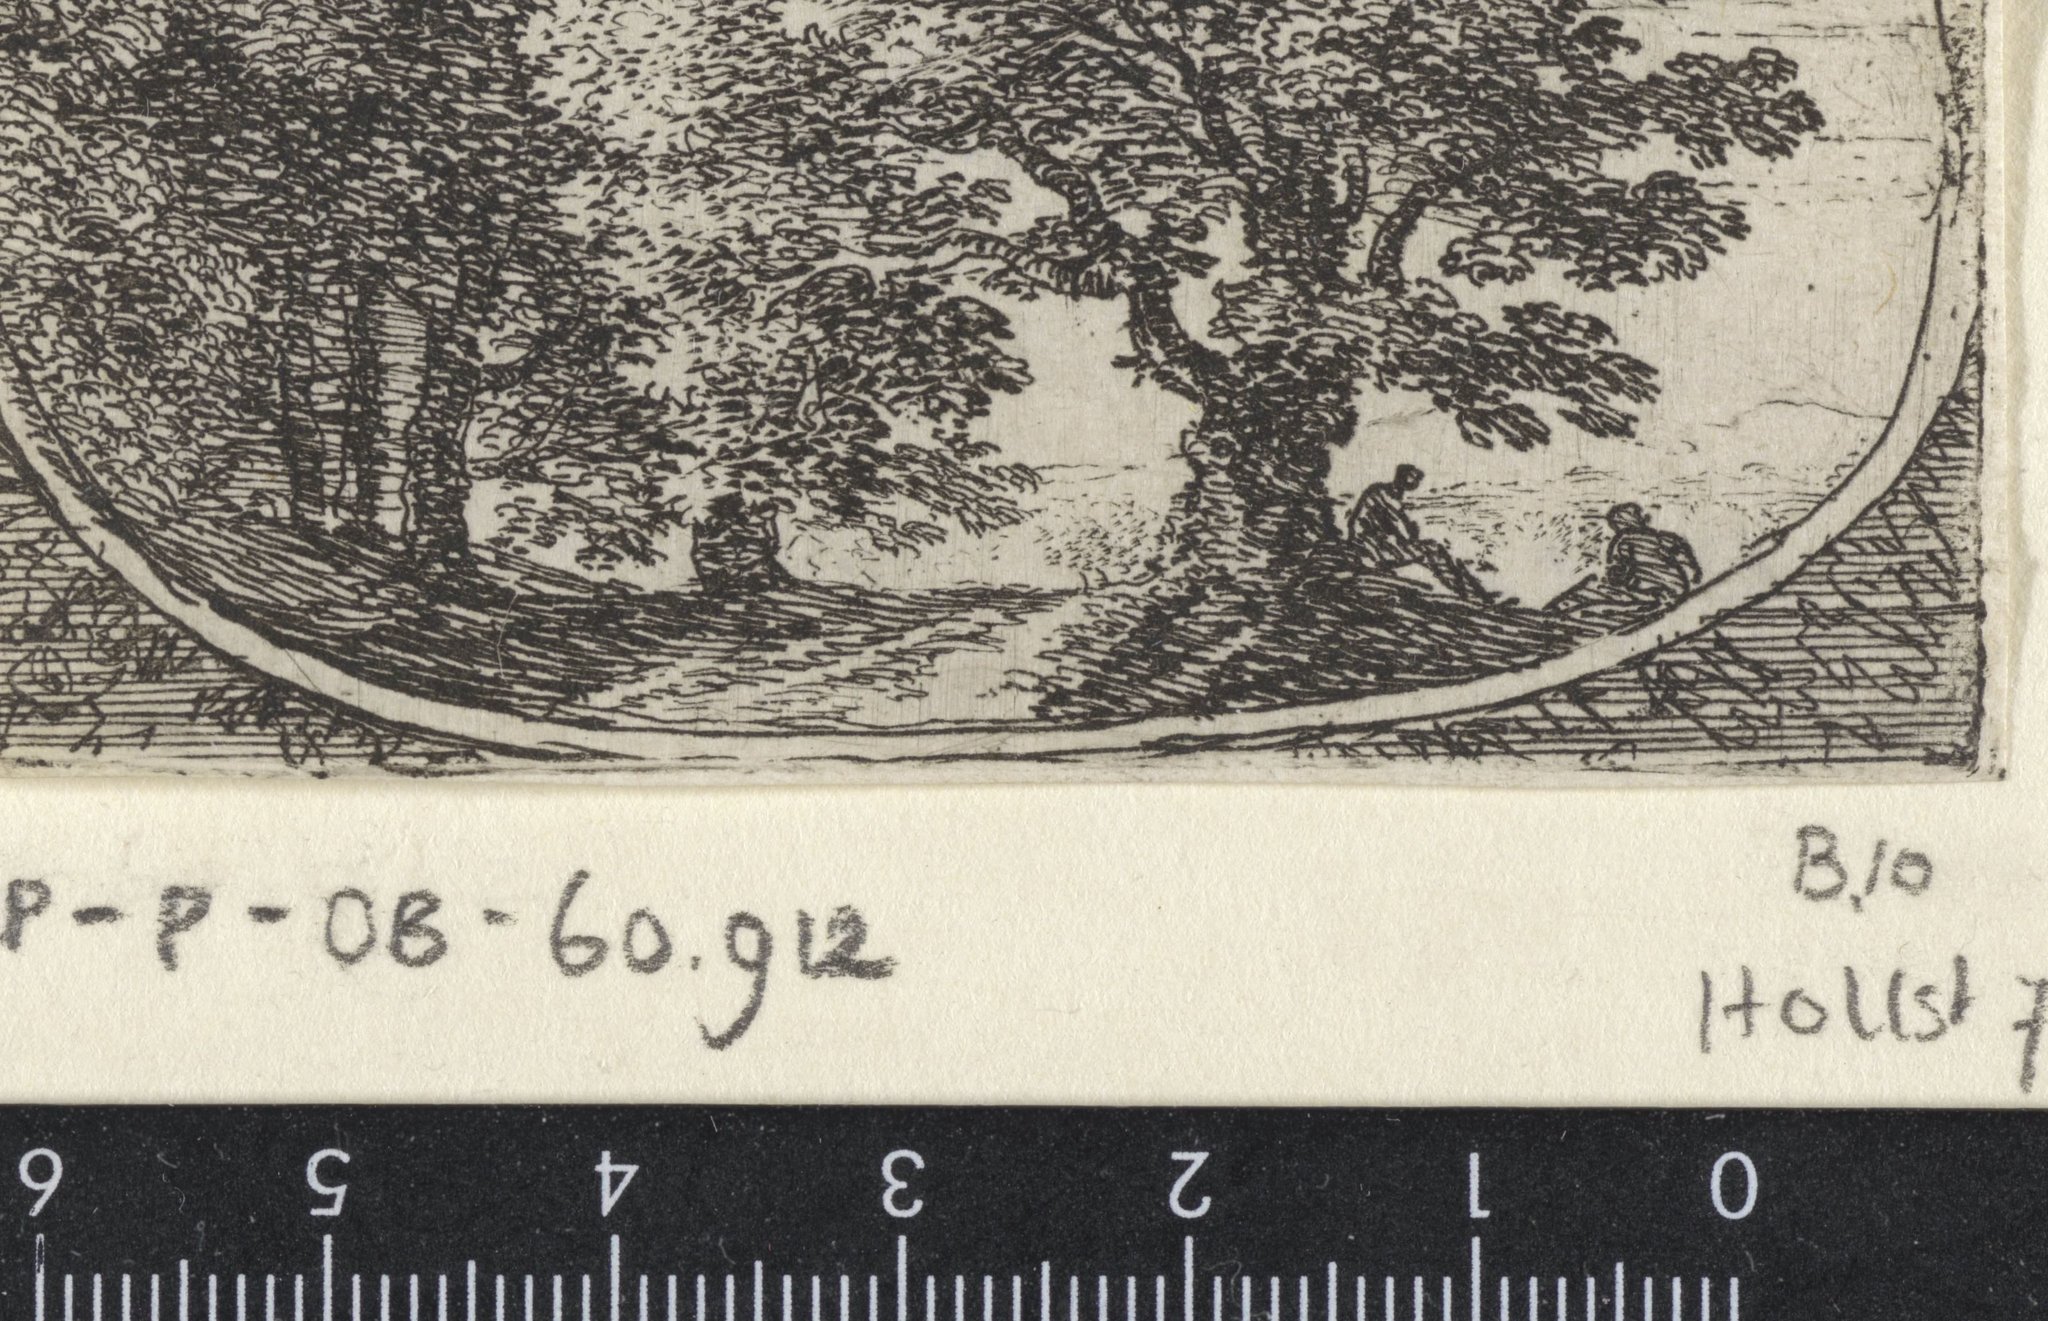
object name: print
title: Variae campestru fantasiae a Hermano van Suanevelt invent et in lucem edita (...)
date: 1650-1655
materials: paper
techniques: etching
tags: landscapes, sitting on the ground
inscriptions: collector's mark: Lugt 2228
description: In een ovale omlijsting zitten twee figuren langs een pad onder een boom.